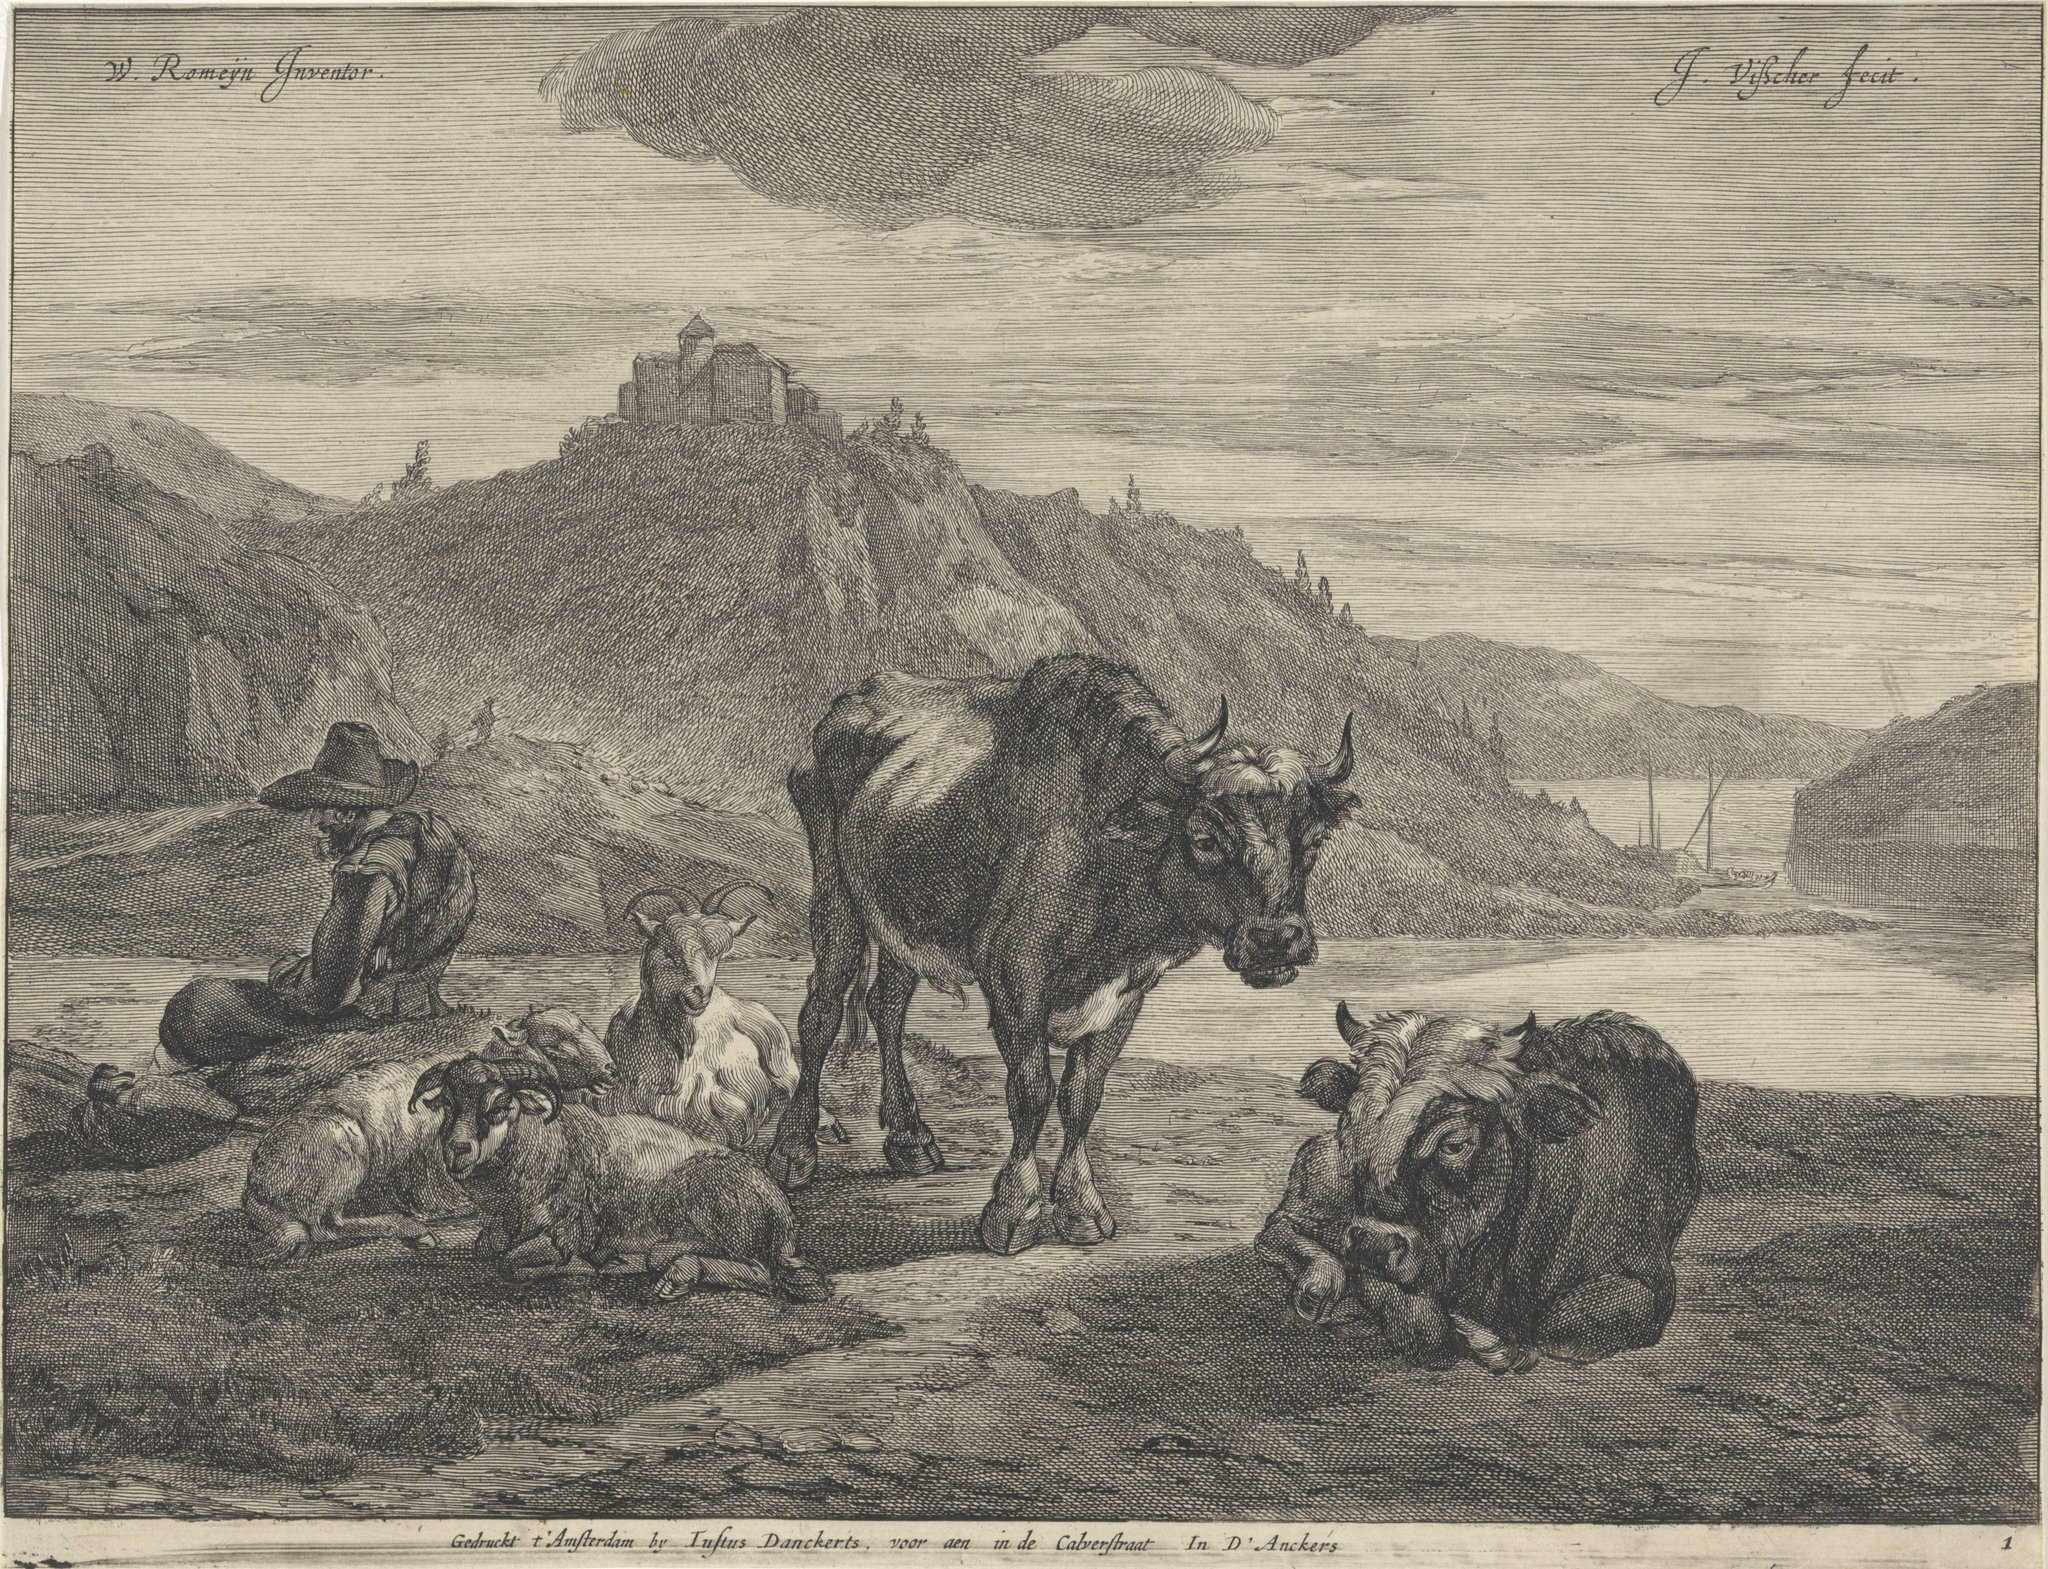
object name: print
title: Landschappen met koeien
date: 1645-1701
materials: paper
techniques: engraving, etching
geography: amsterdam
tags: cow, river, herding, herdsman, herdswoman, shepherd, shepherdess, cowherd, etc.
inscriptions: collector's mark: Lugt 240